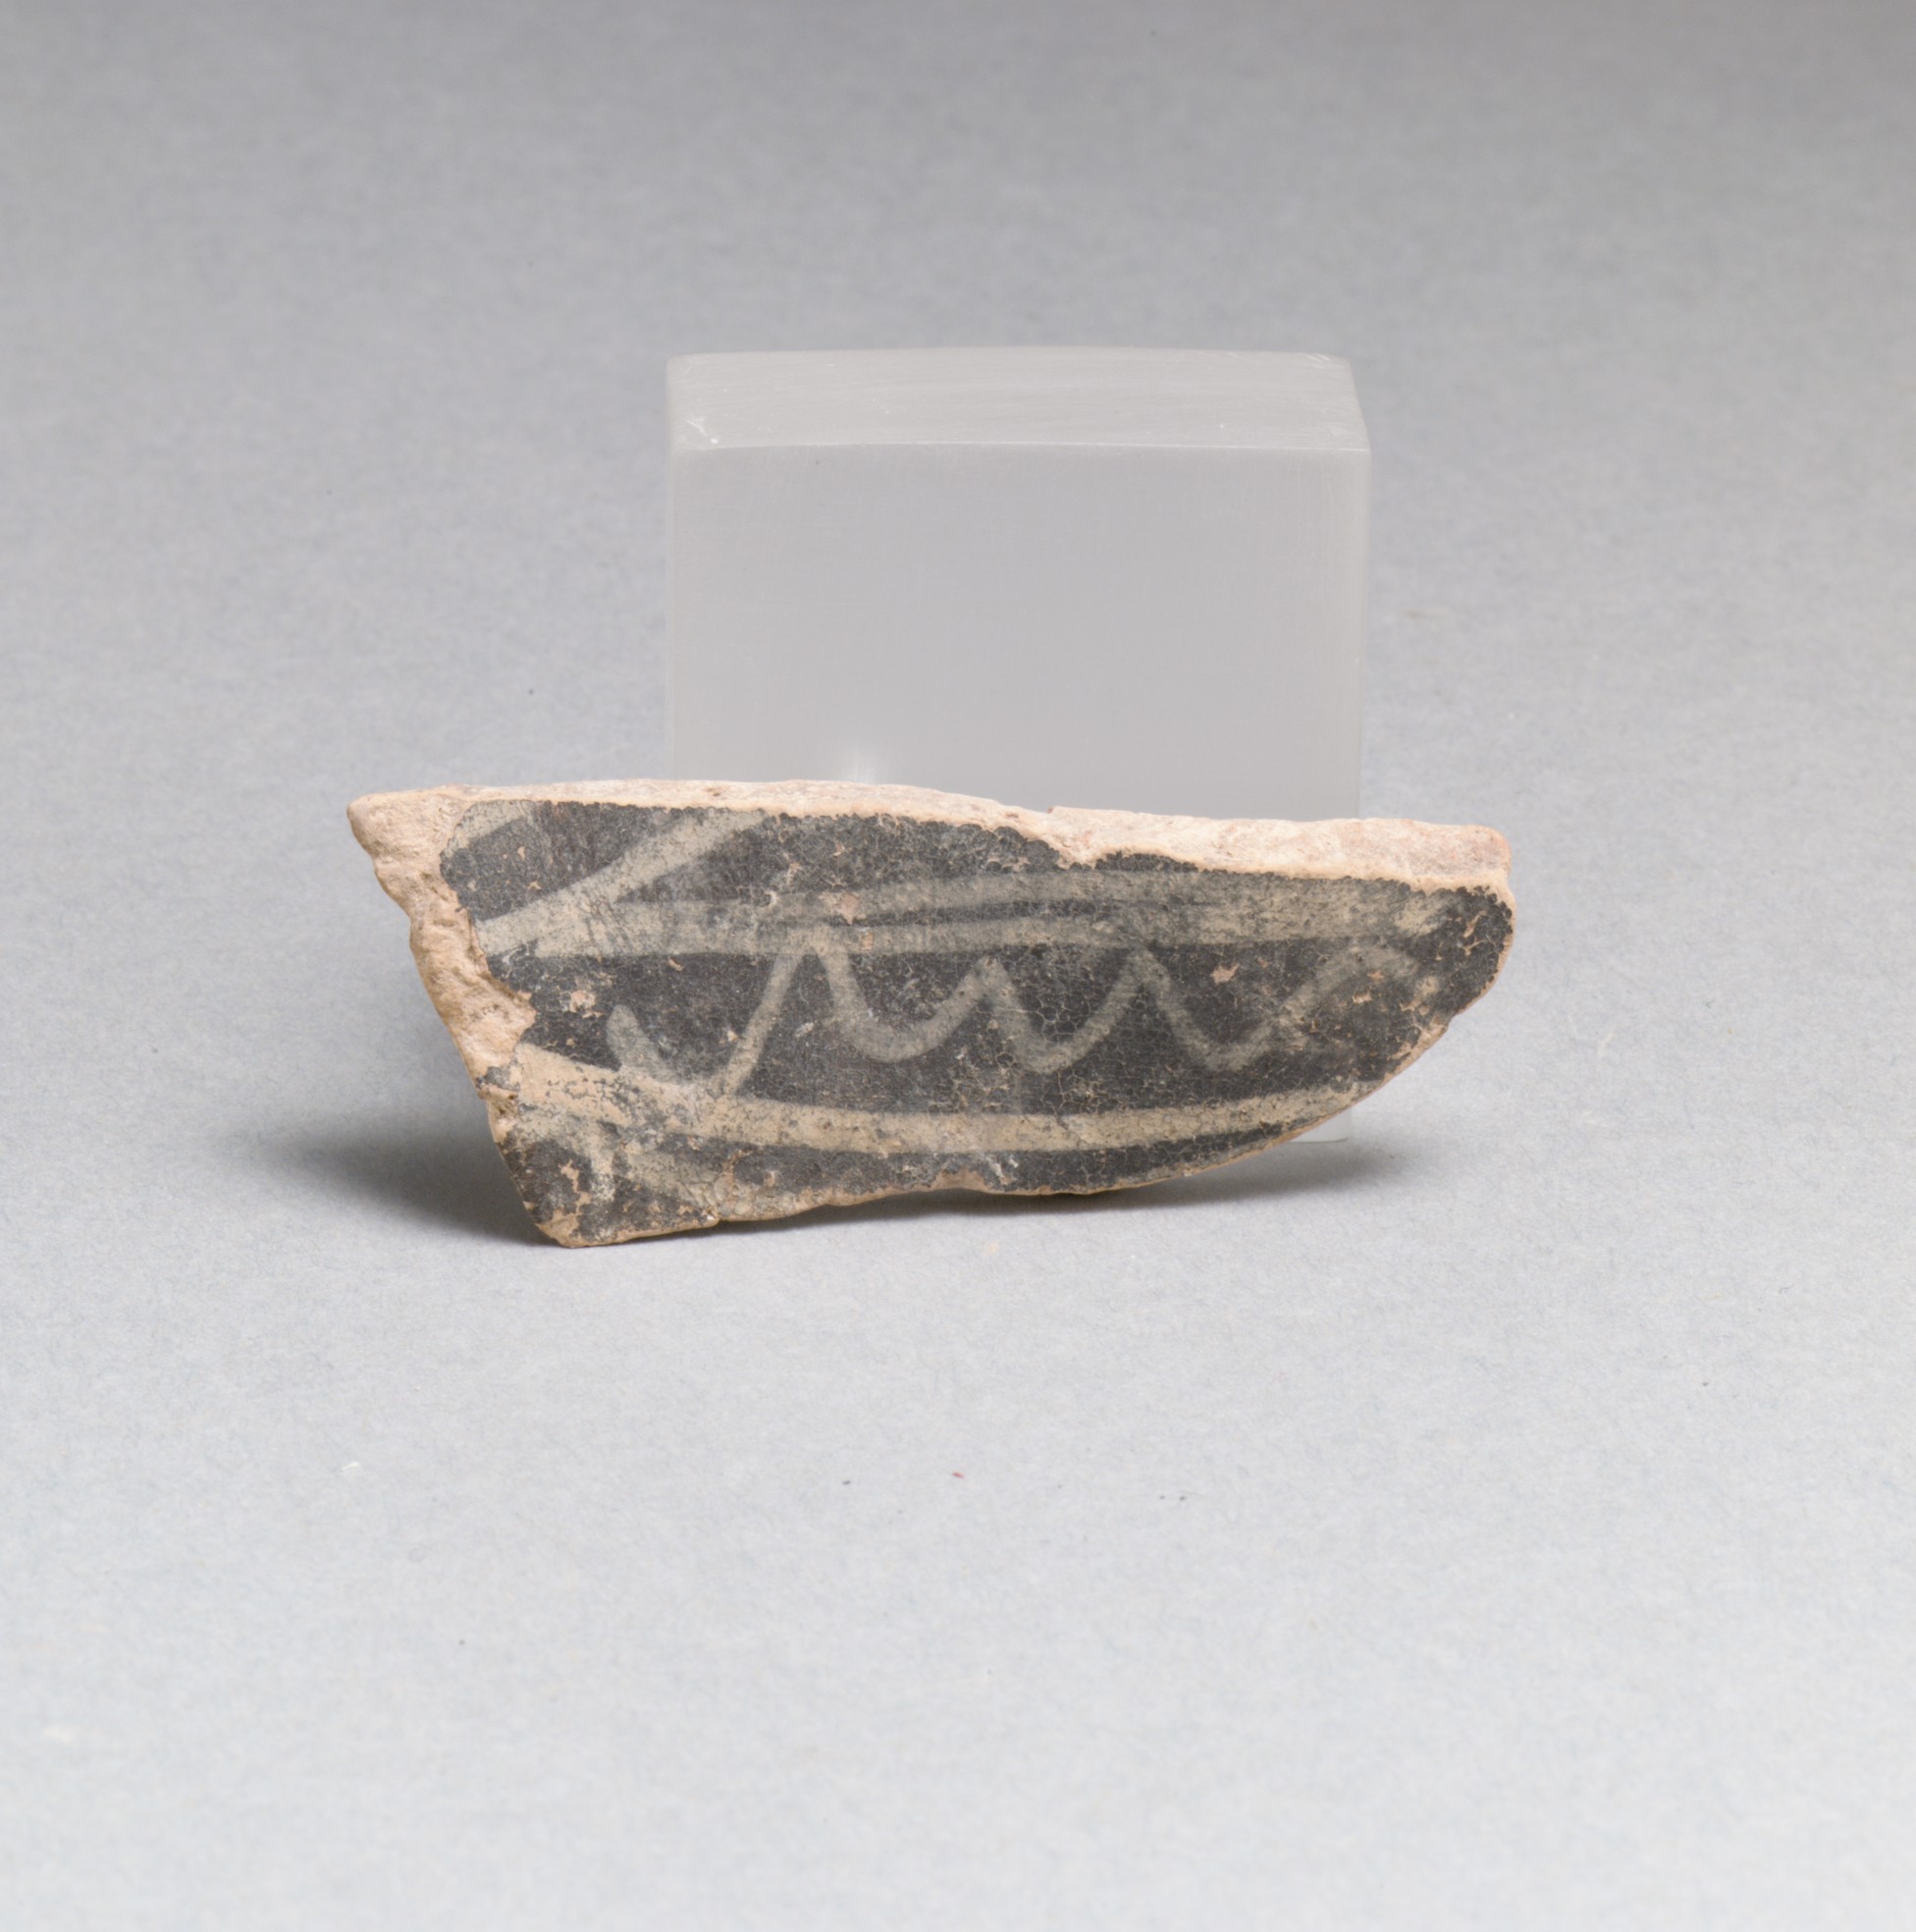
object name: vase fragment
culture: minoan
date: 2600-2000 BCE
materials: terracotta